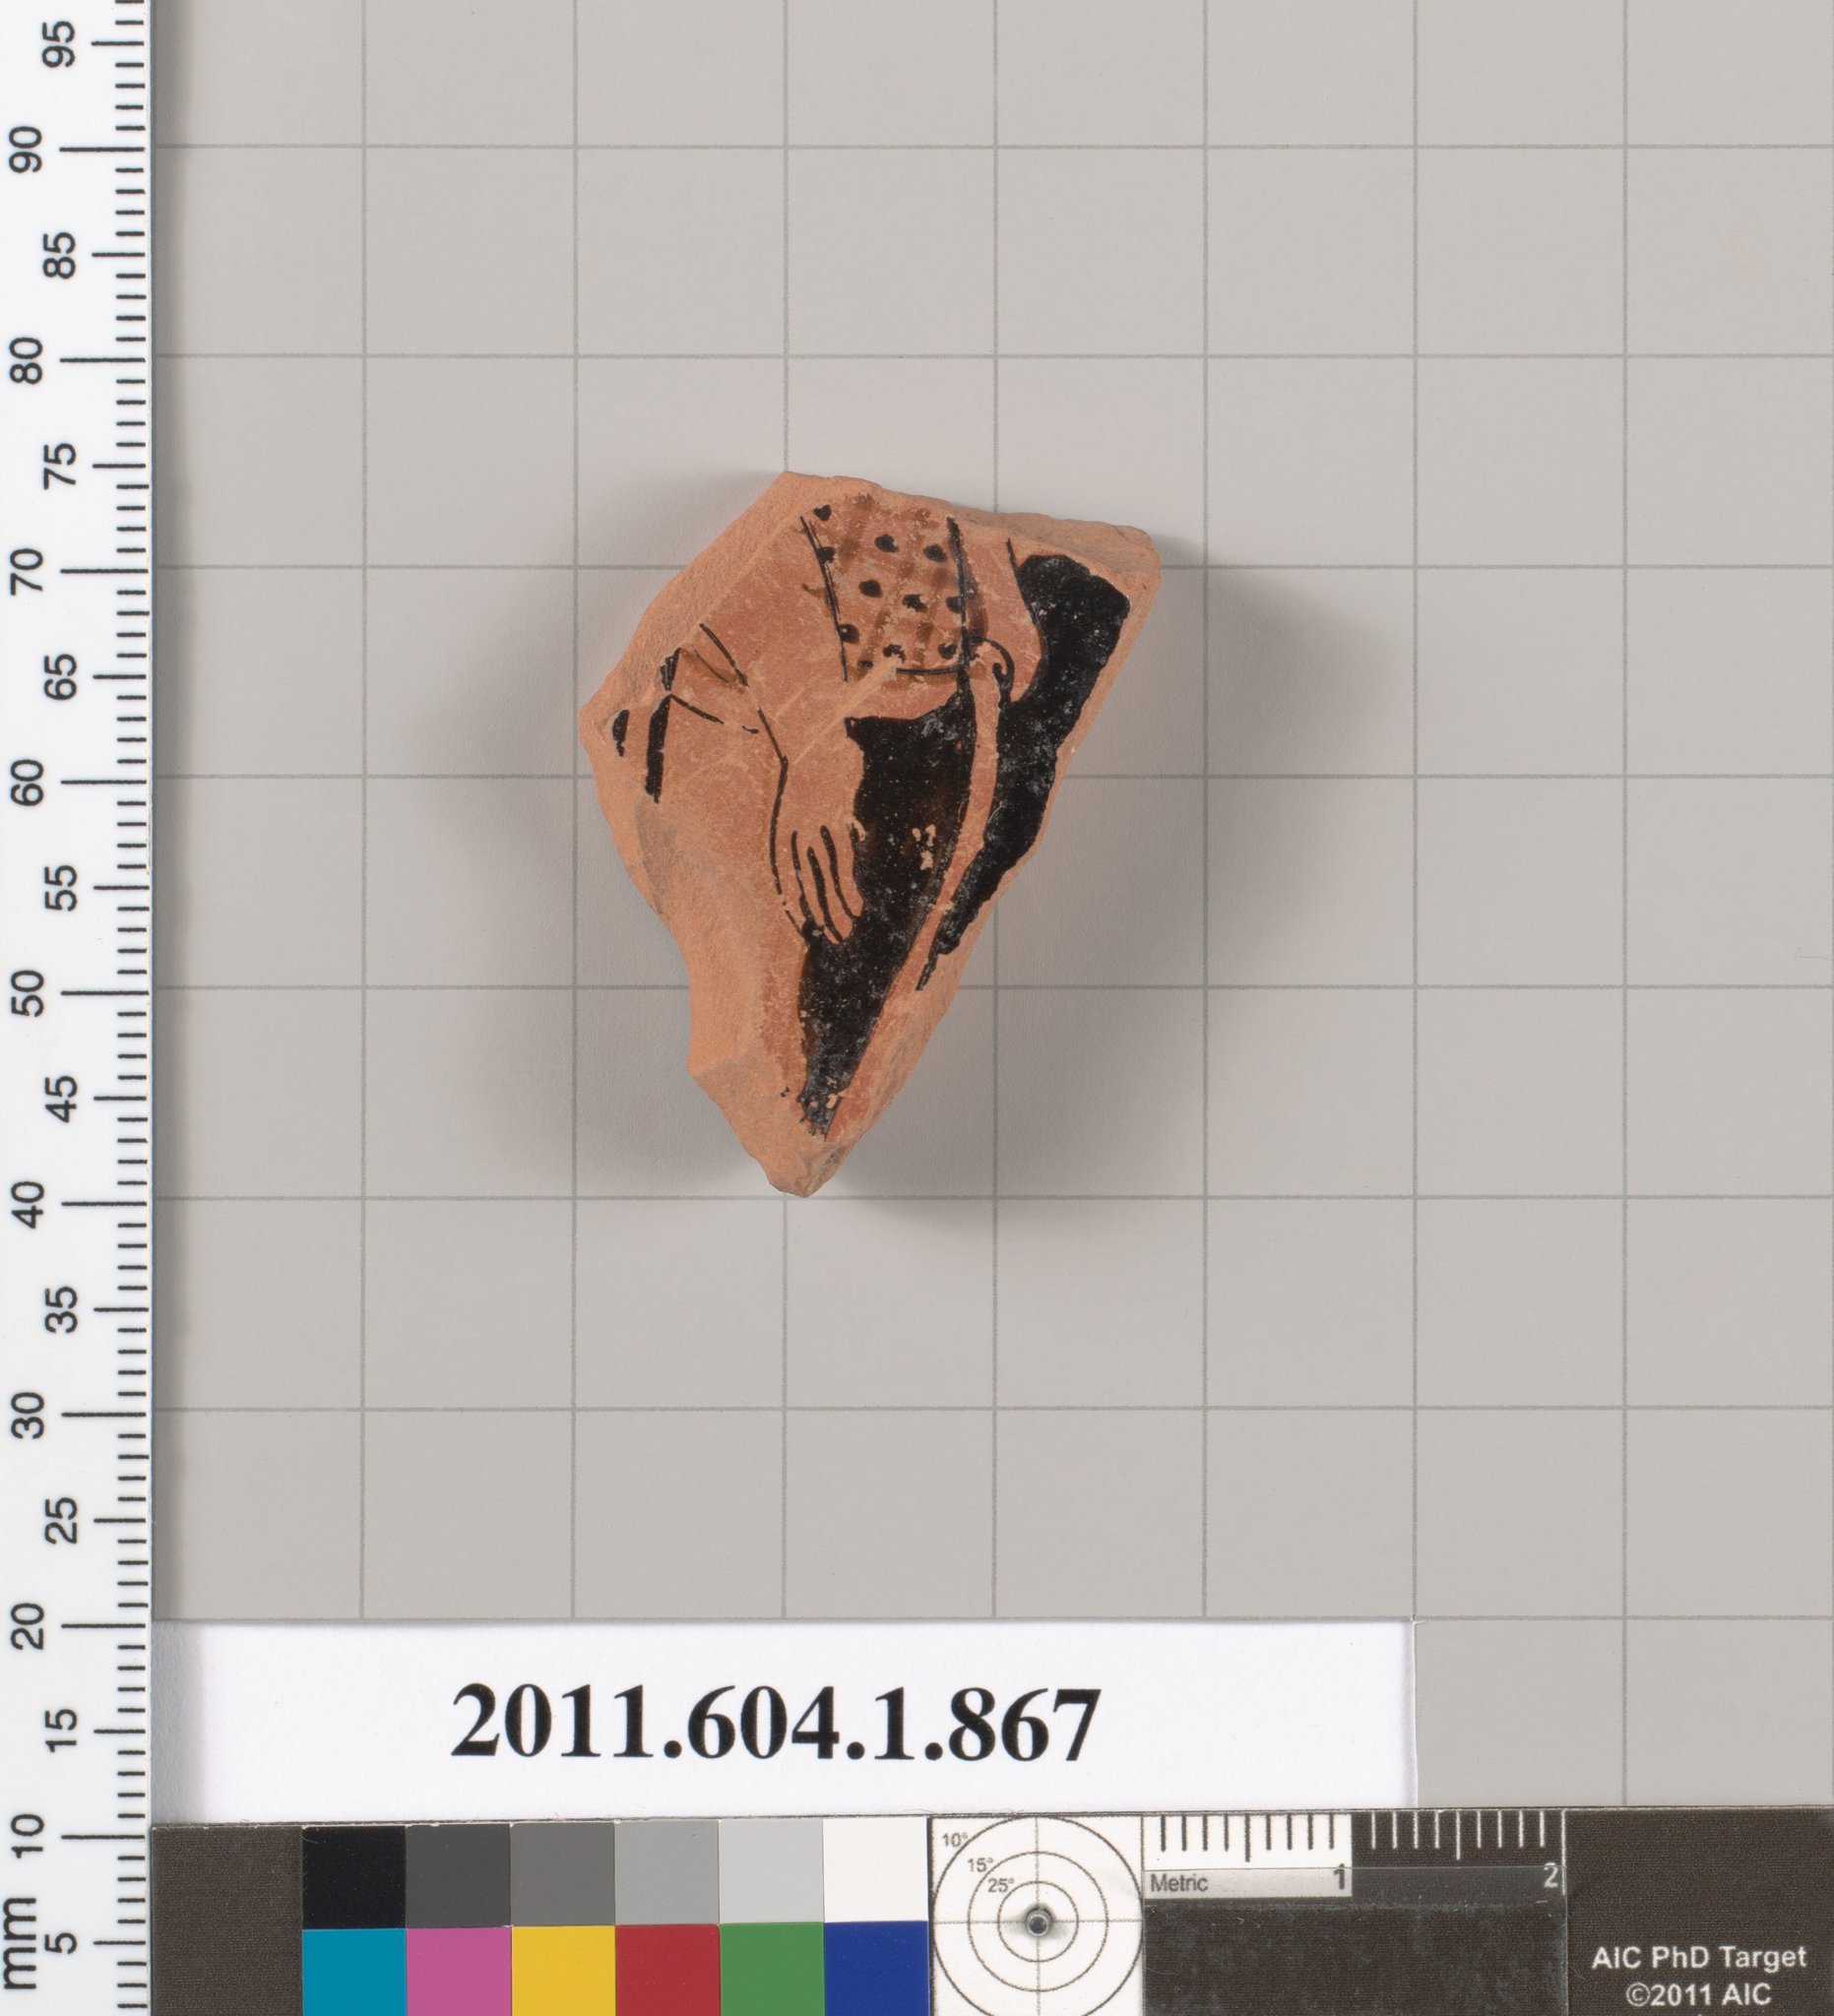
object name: kylix fragment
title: Terracotta fragment of a kylix (drinking cup)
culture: greek, attic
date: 475-451 BCE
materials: terracotta